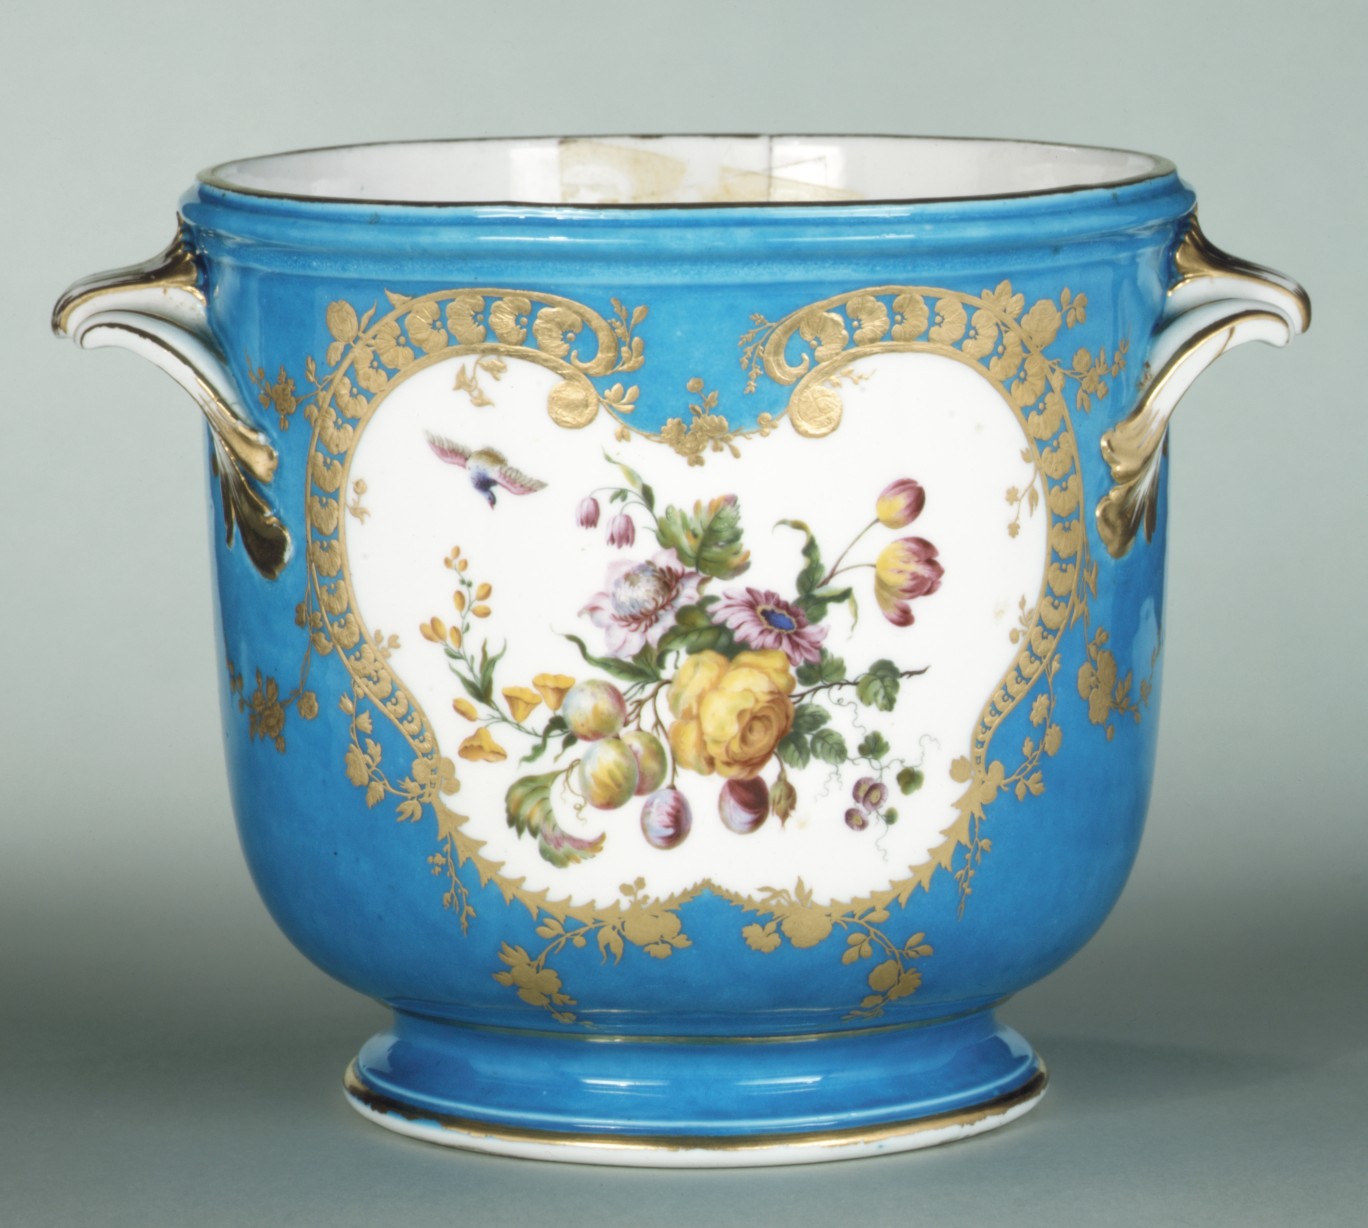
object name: cooler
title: Bottle cooler from the Louis XV service (seau à bouteille)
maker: vincennes manufactory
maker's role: manufactory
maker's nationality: french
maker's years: 1740-1756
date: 1753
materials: enamel, gold, soft paste porcelain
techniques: polychrome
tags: birds,flowers